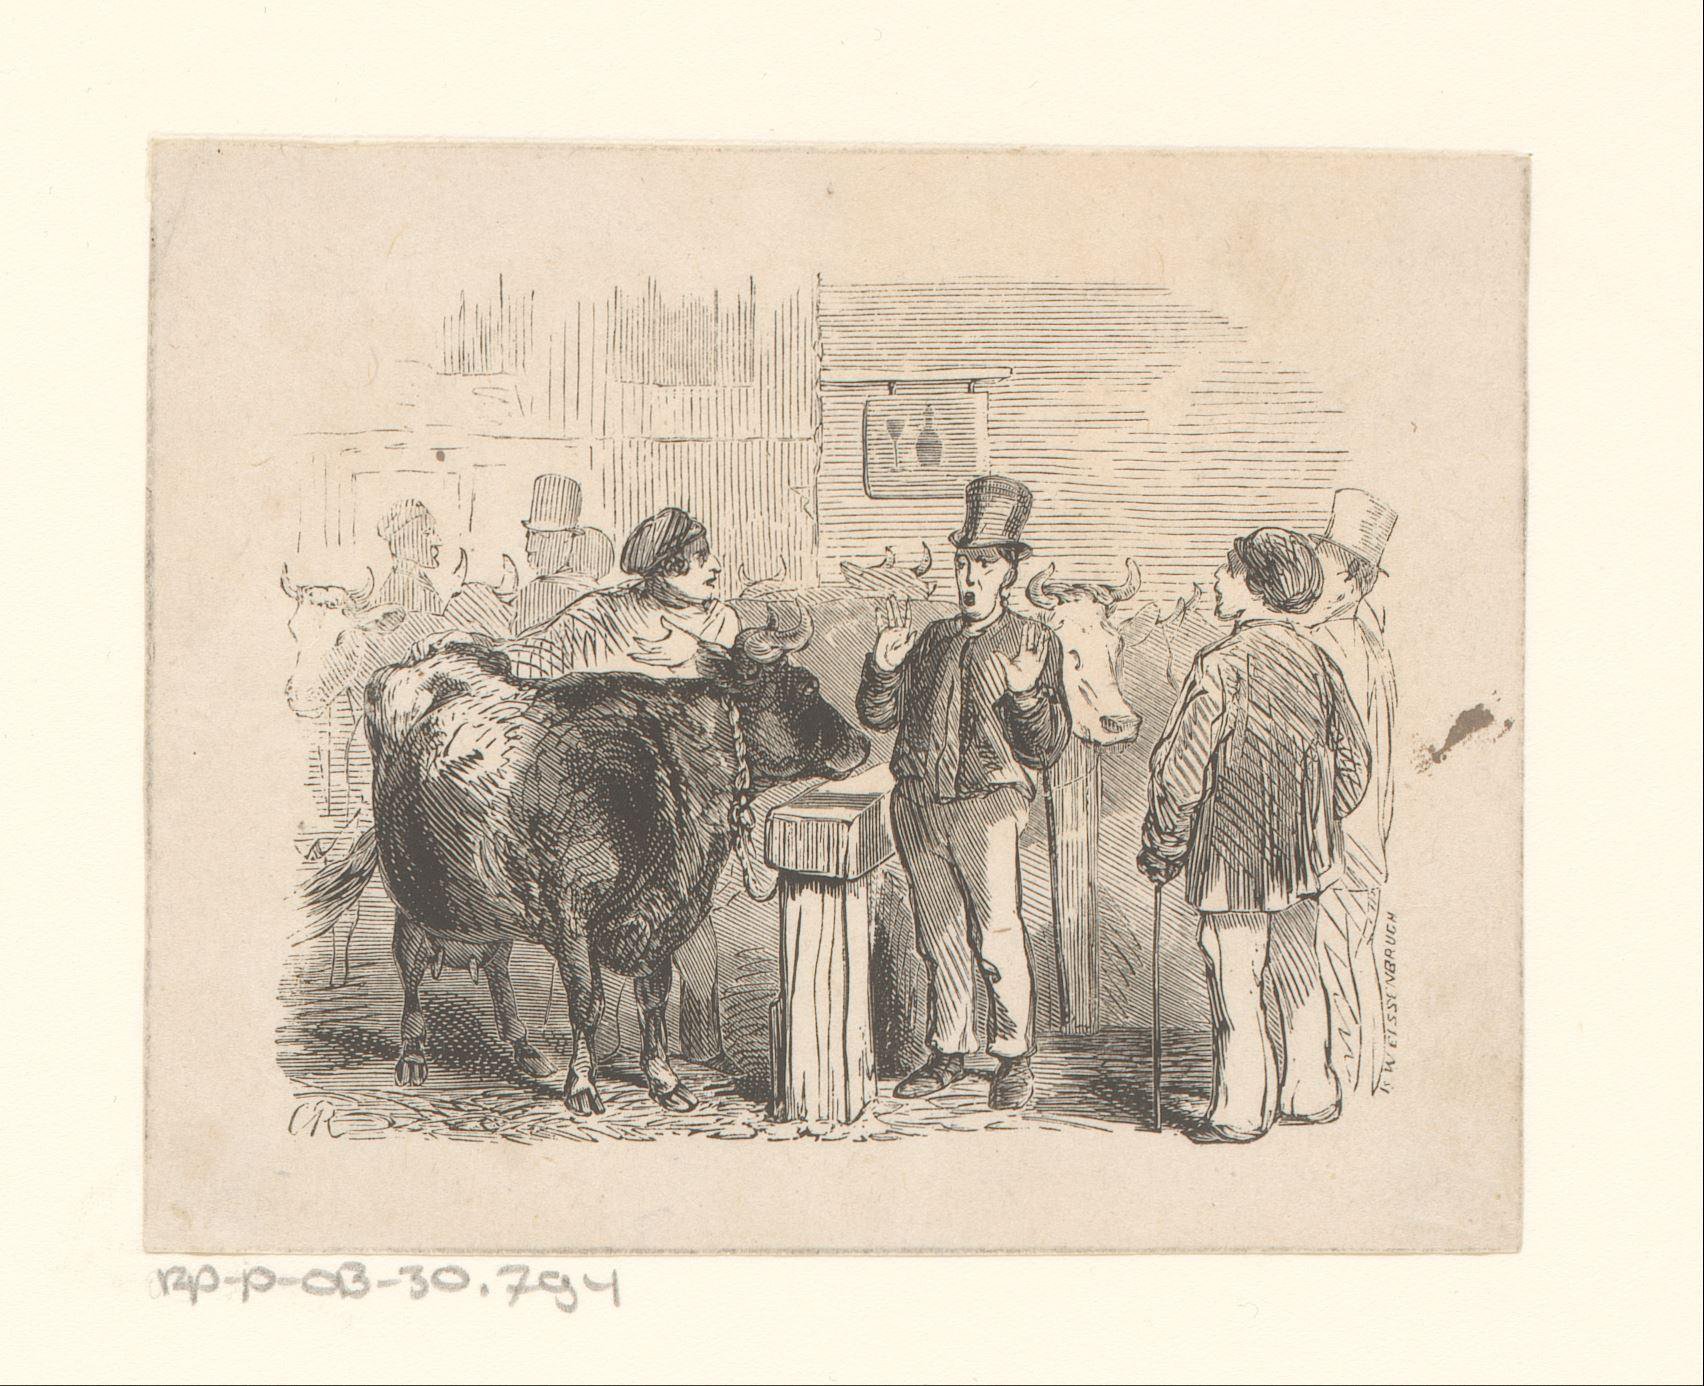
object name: print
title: Mannen met elkaar pratend op een veemarkt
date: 1836-1912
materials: paper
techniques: engraving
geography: netherlands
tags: cattle, adult man (+ standing), market-hall